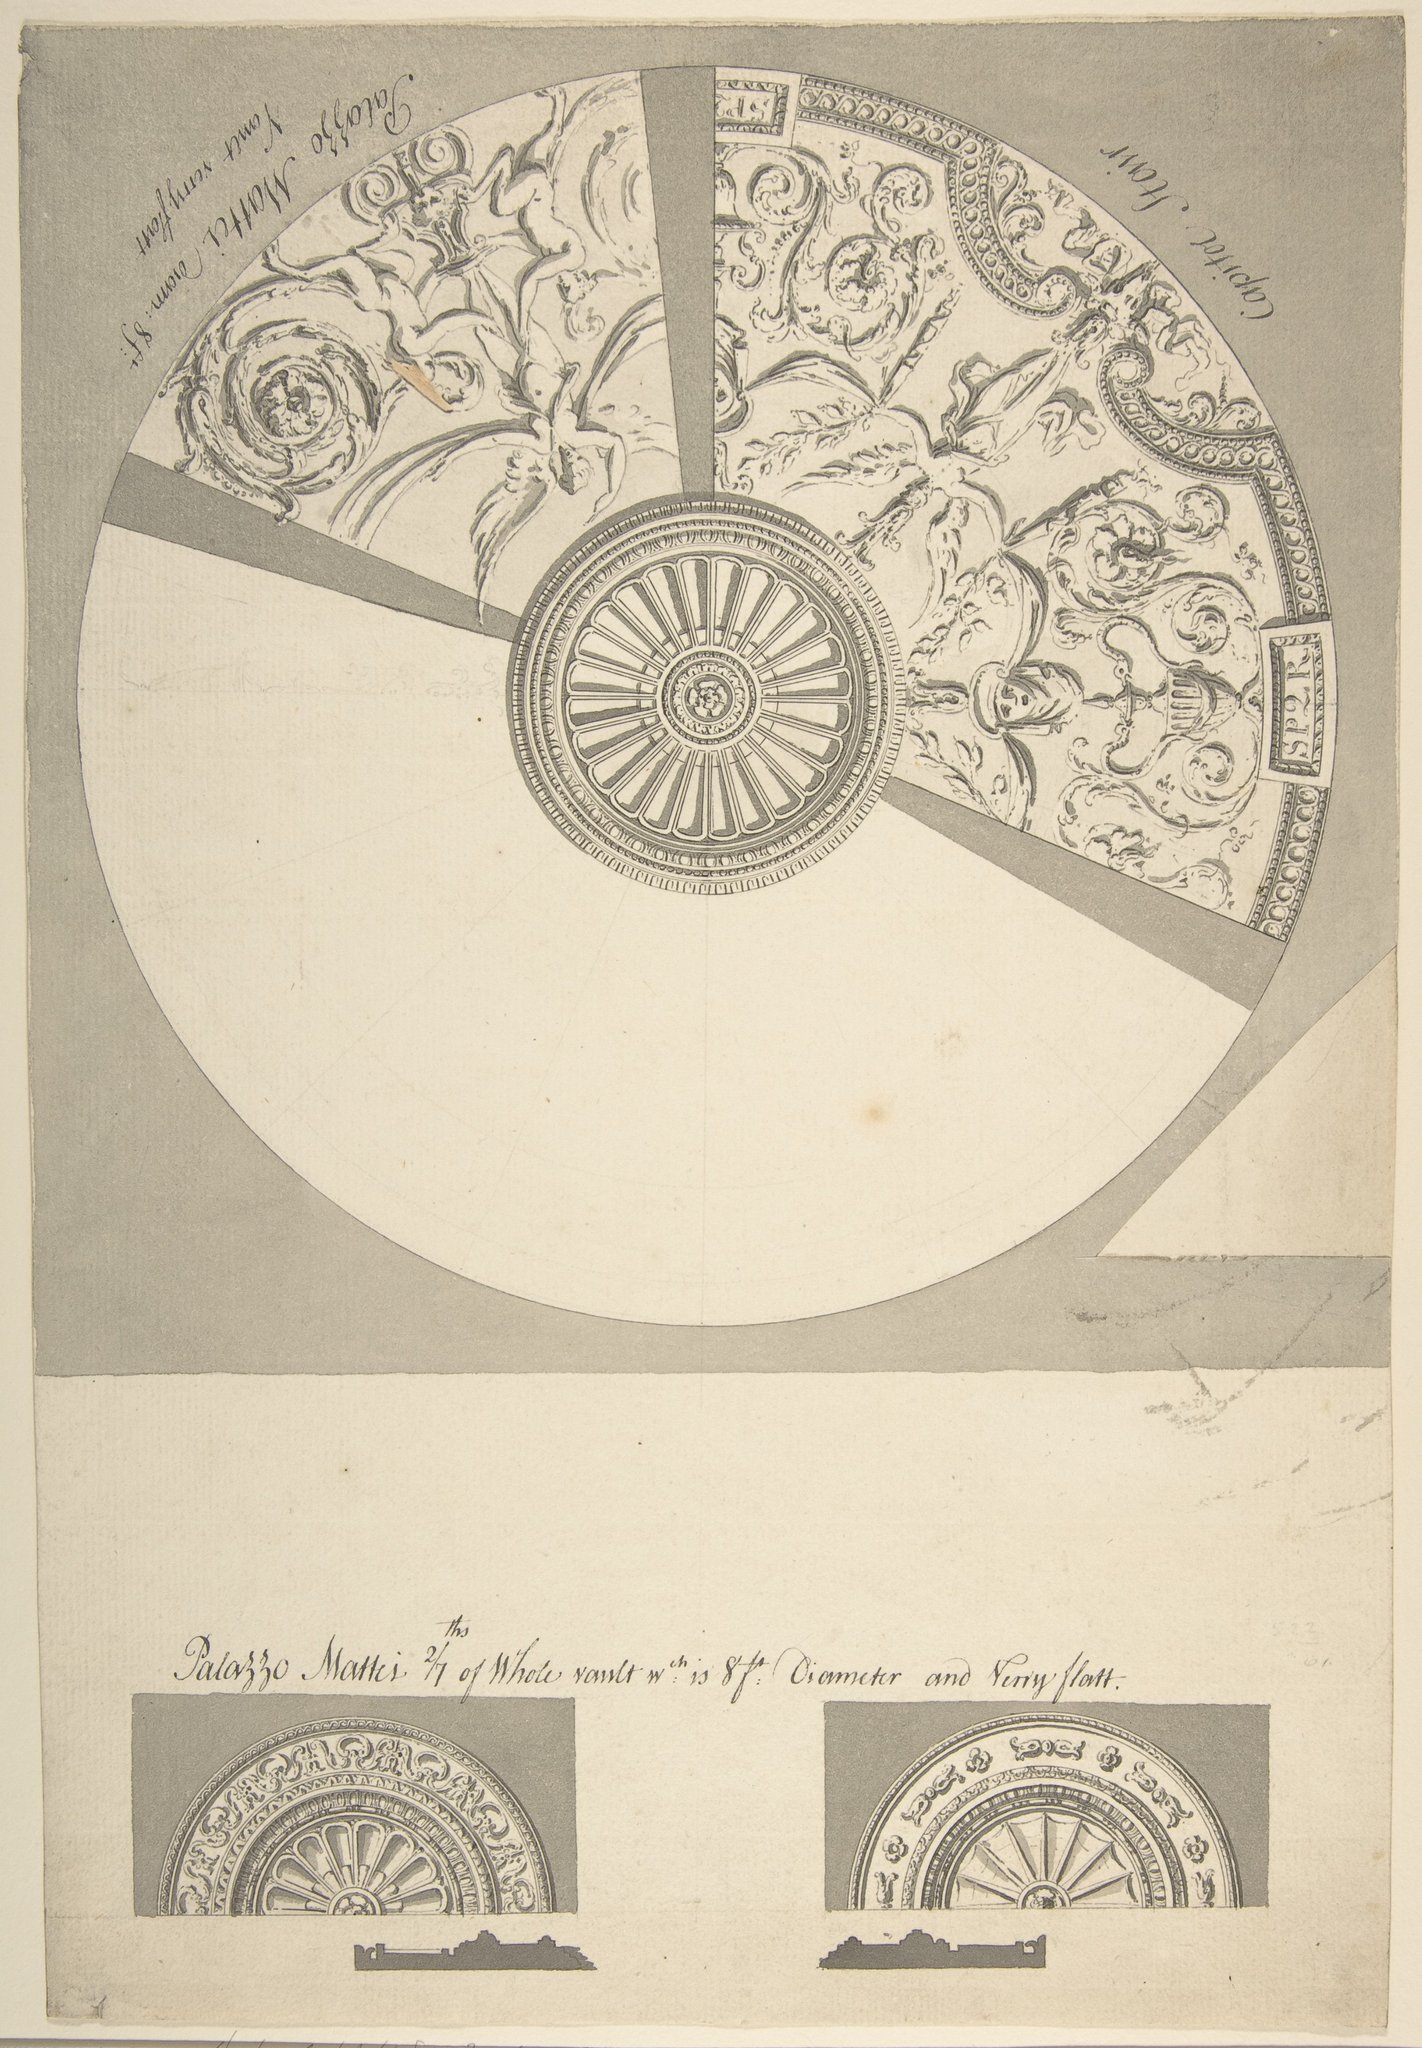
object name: drawing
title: Ceiling Vault of Palazzo Mattei, Rome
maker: sir william chambers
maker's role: artist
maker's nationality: british, born sweden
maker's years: 1723-1796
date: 1750-1759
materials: ink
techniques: brush, pen, wash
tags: architecture,ceilings